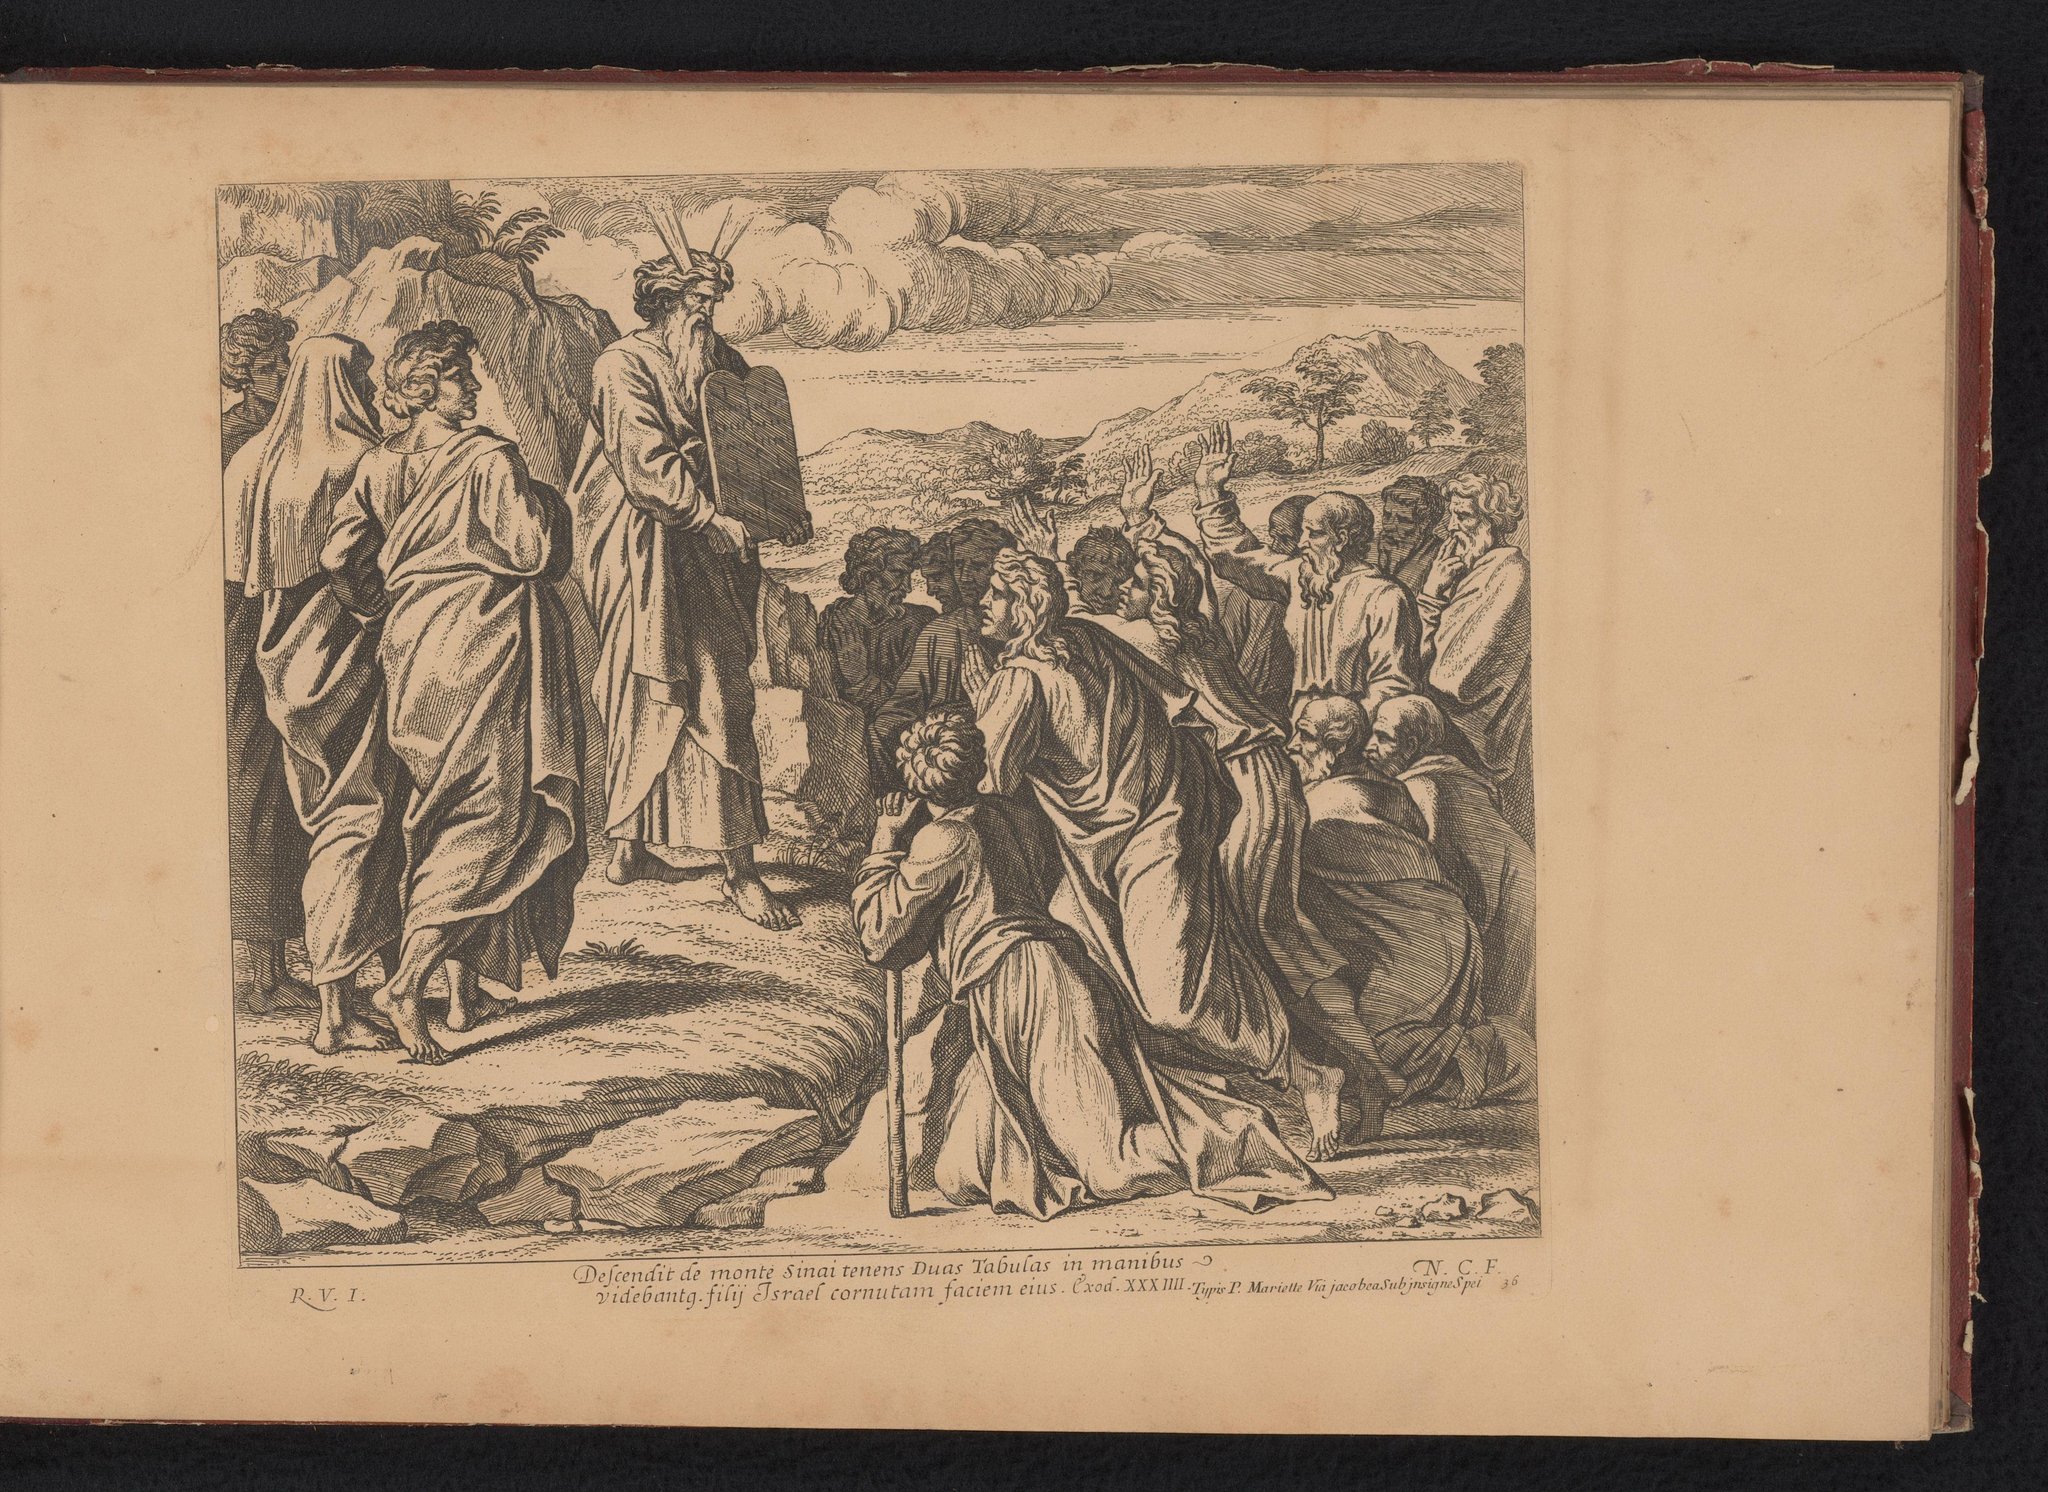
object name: print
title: Sacrae historiae acta a Raphael Urbin in Vaticanis xystis ad picturae miraculum expressa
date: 1649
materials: paper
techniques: etching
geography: paris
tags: god comes down in the pillar of cloud at the door of the tabernacle and rebukes aaron and miriam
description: Deze prent maakt deel uit van een album.